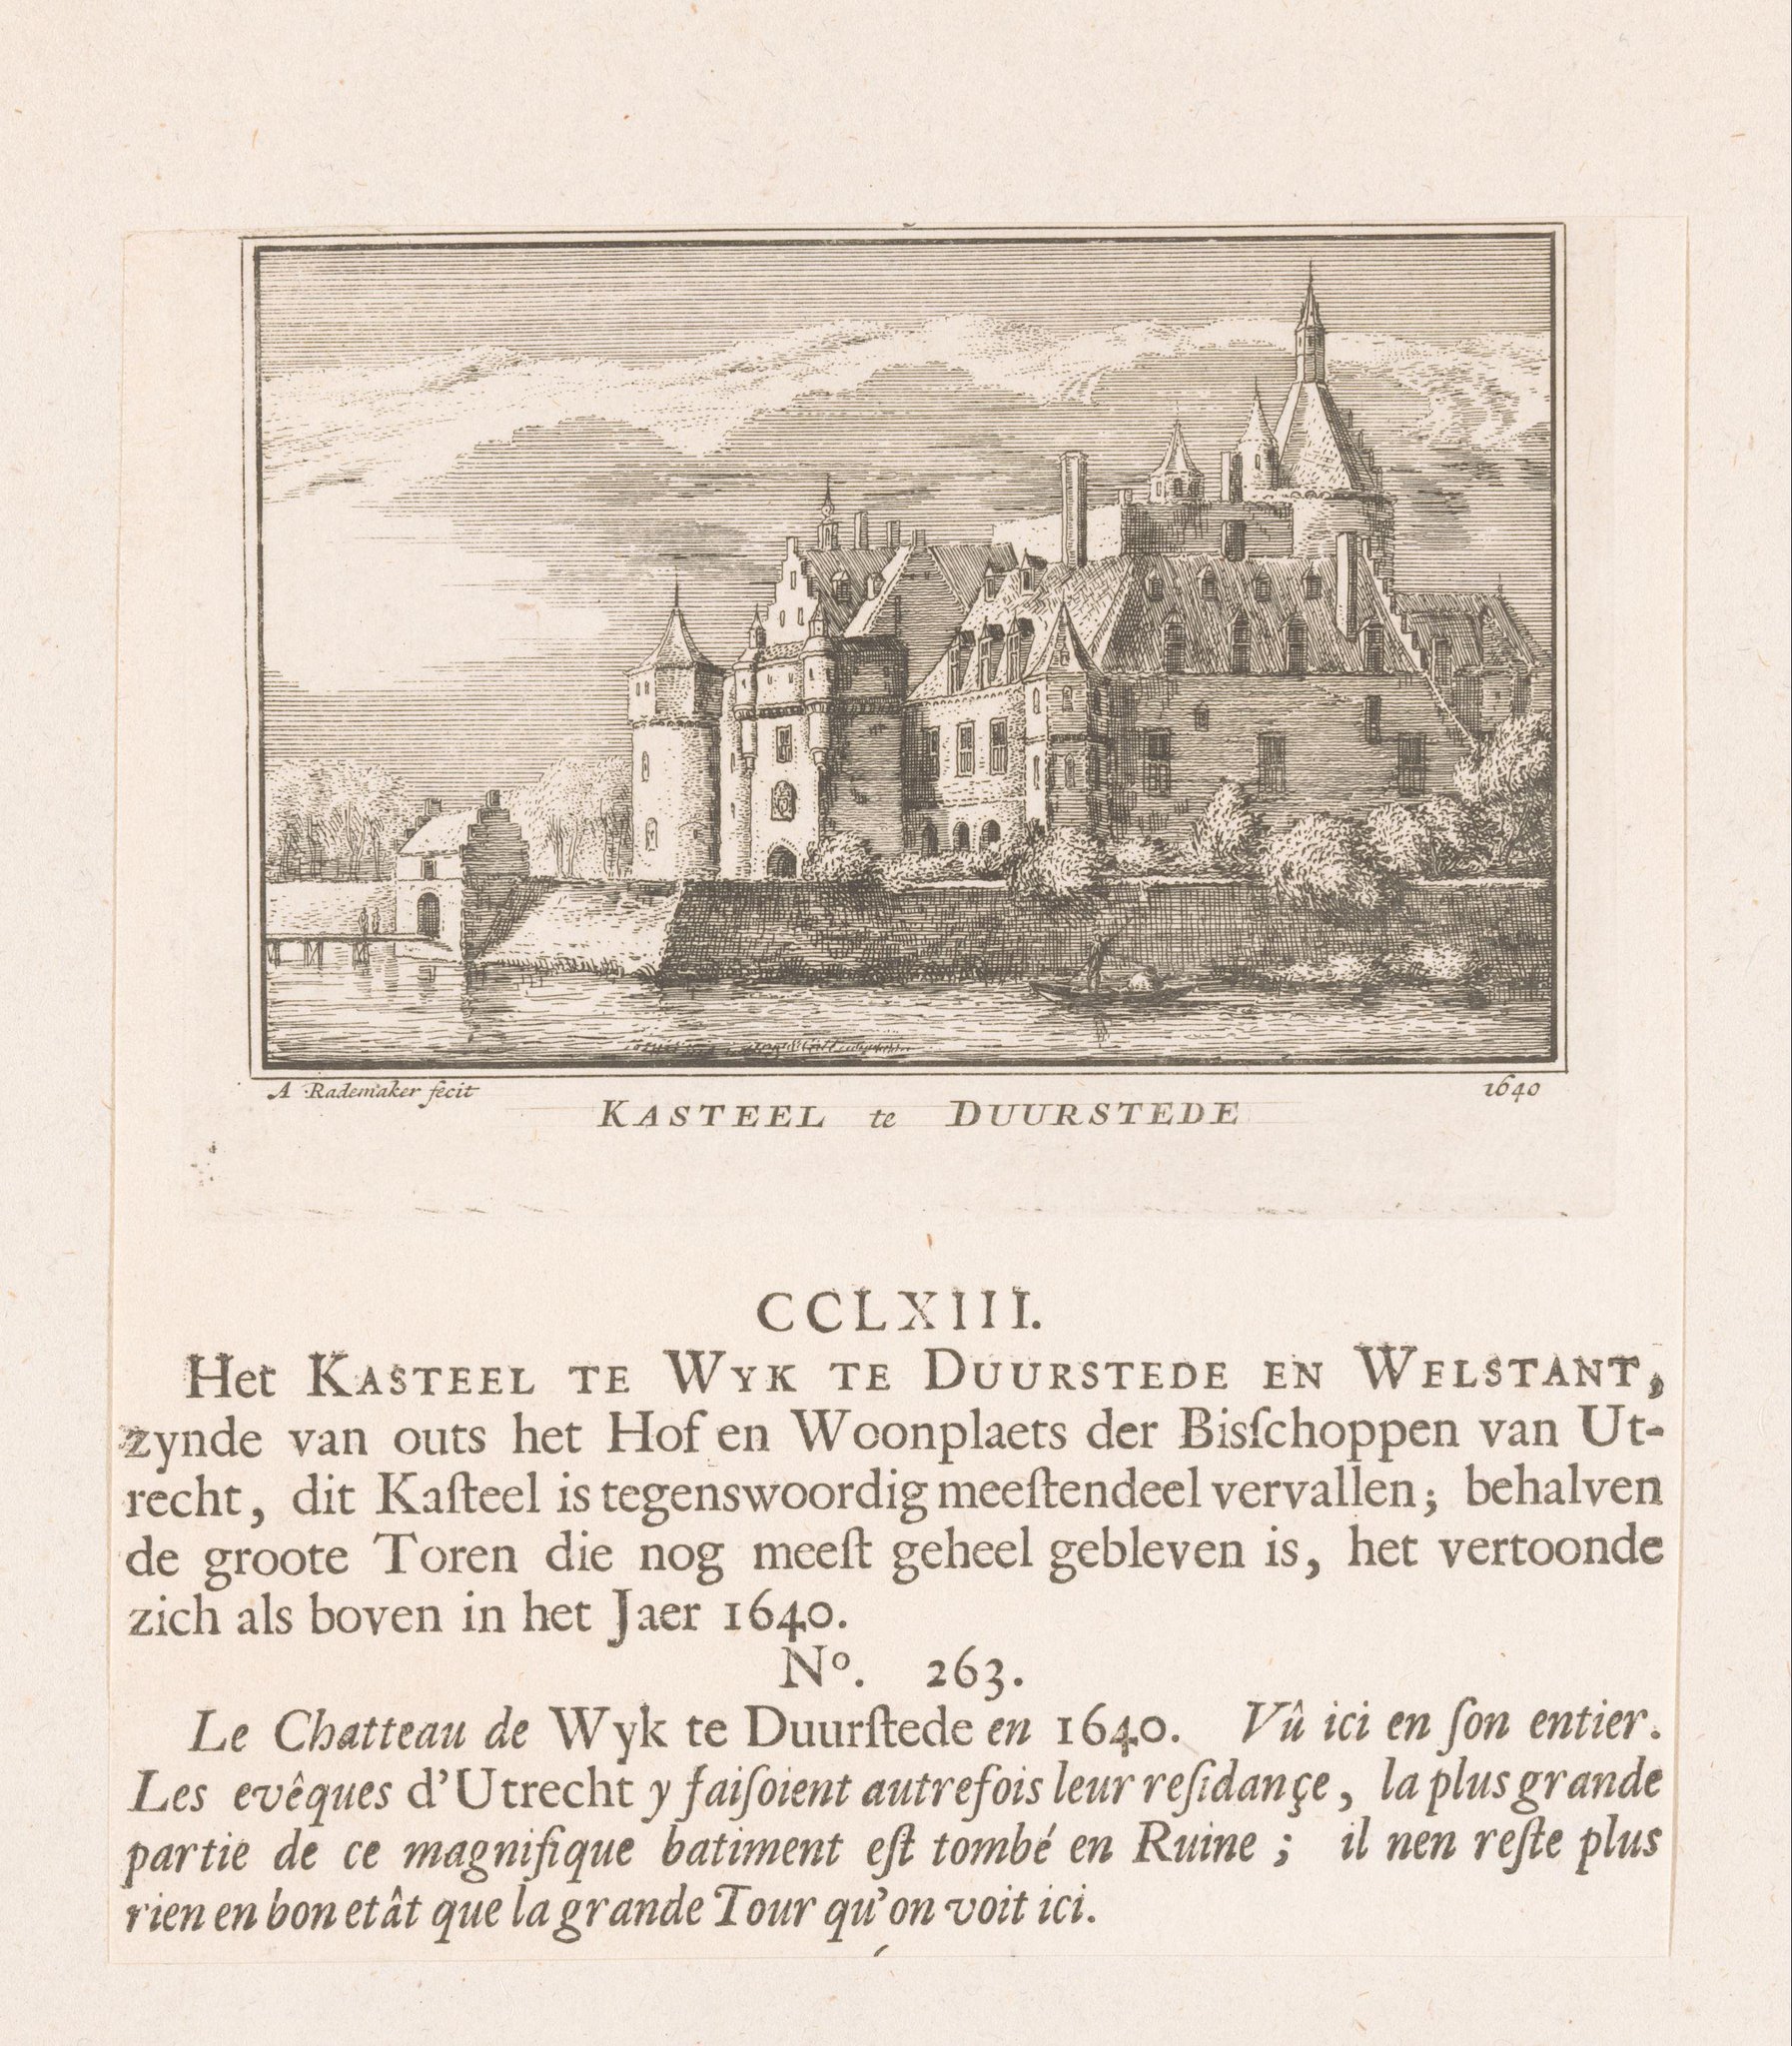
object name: print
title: Kasteel te Duurstede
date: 1725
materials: paper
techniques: engraving, etching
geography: amsterdam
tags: castle, landscape with tower or castle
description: Prent uit: Rademaker, Abraham. Kabinet van Nederlandsche outheden en gezichten (...). Amsterdam: Willem Barents, 1725, nr. 263.